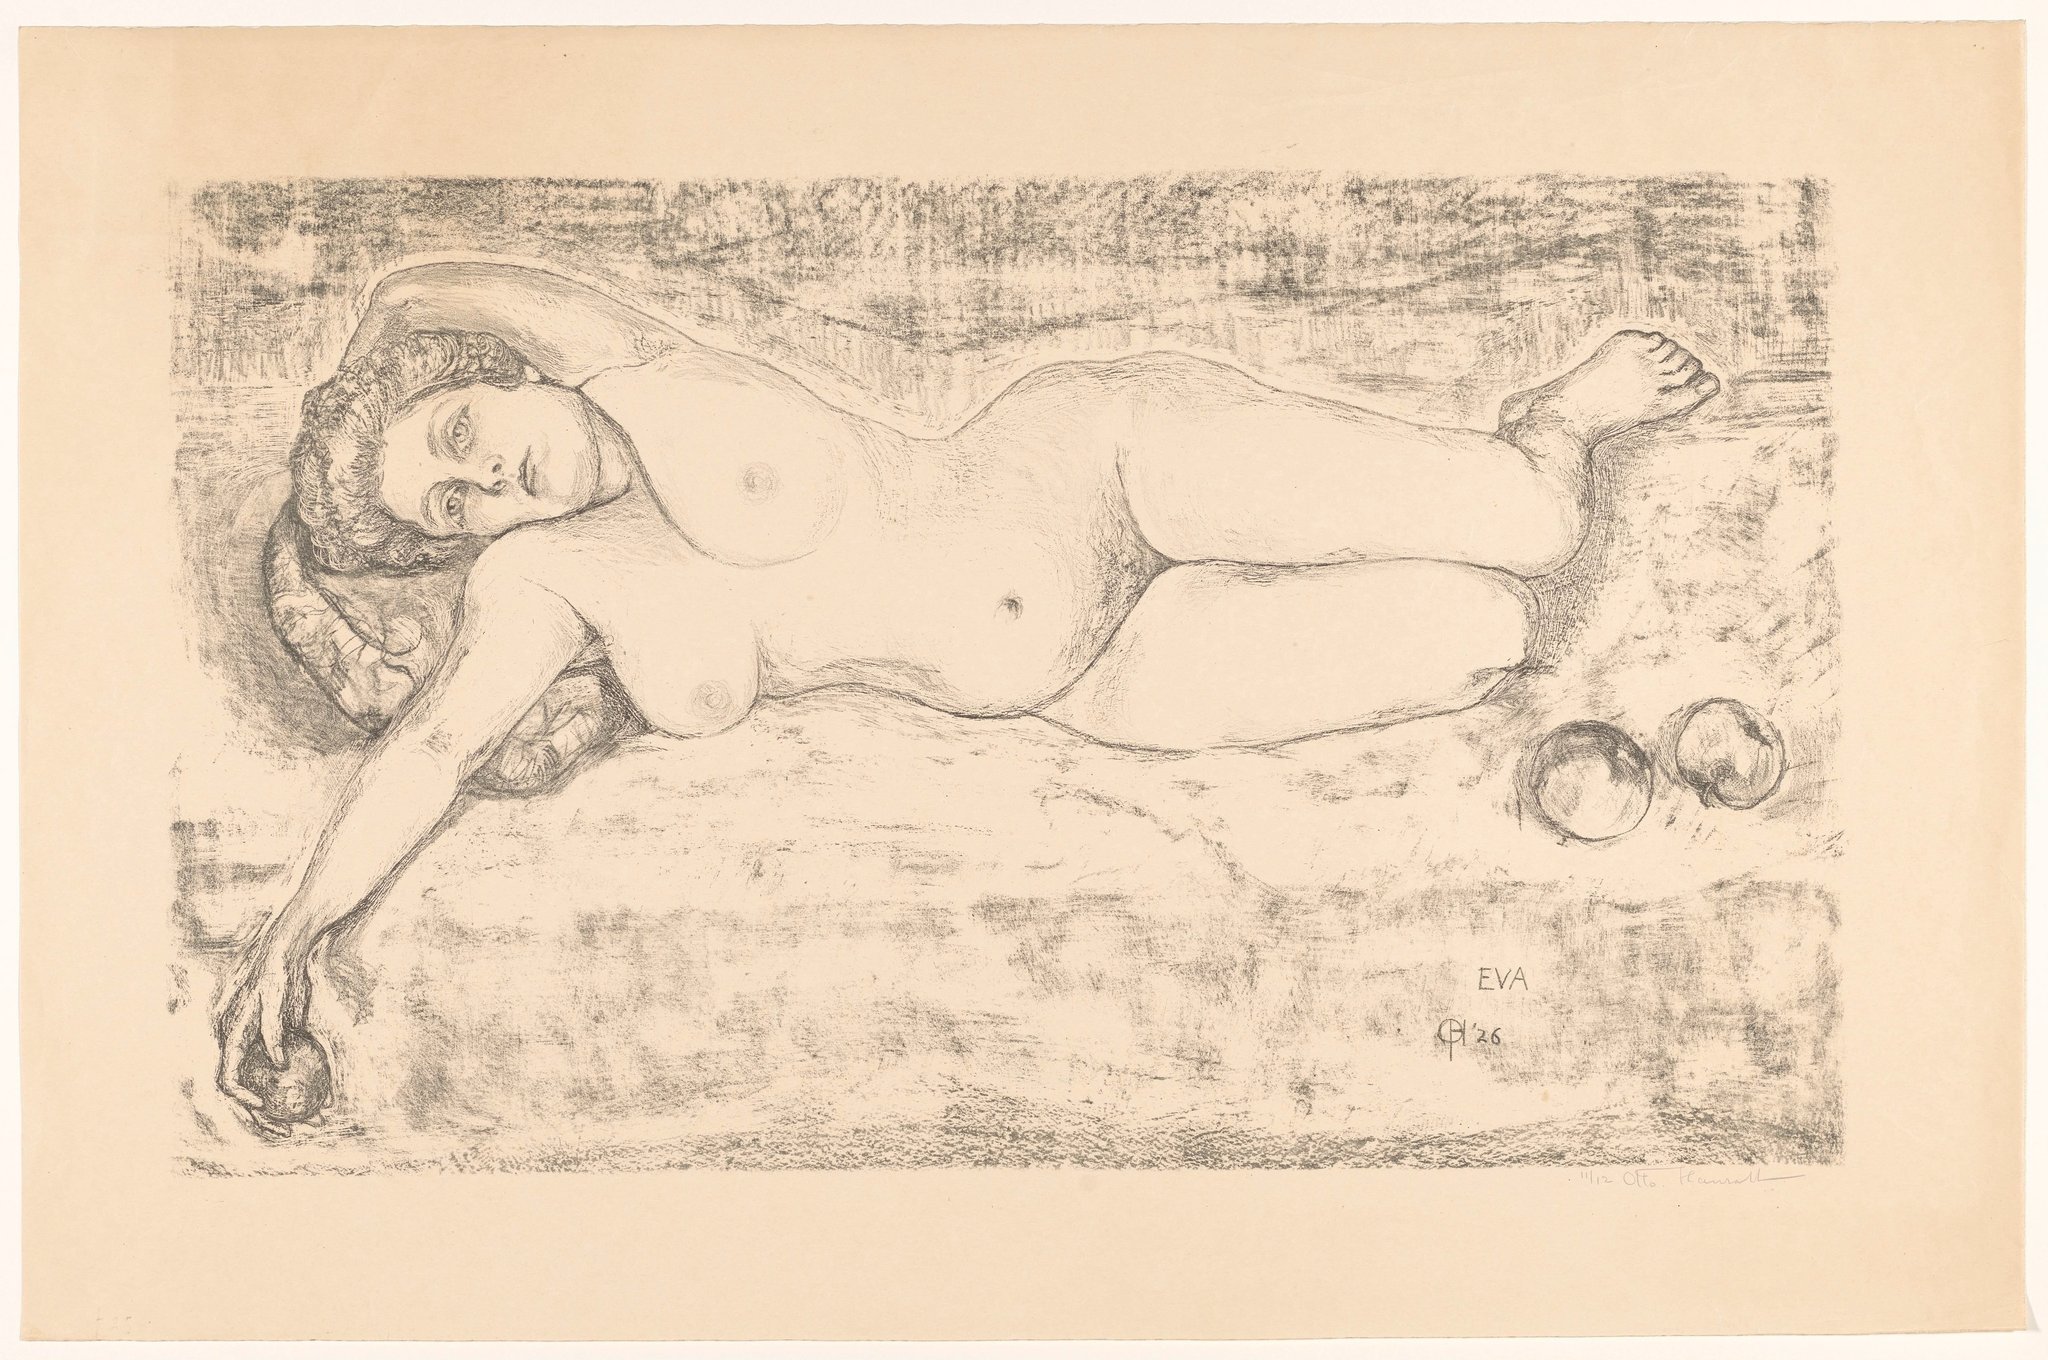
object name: print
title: Eva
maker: otto hanrath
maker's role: print maker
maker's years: 1882-1944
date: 1926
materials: paper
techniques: lithograph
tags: eve takes the fruit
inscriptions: collector's mark: Lugt 2228